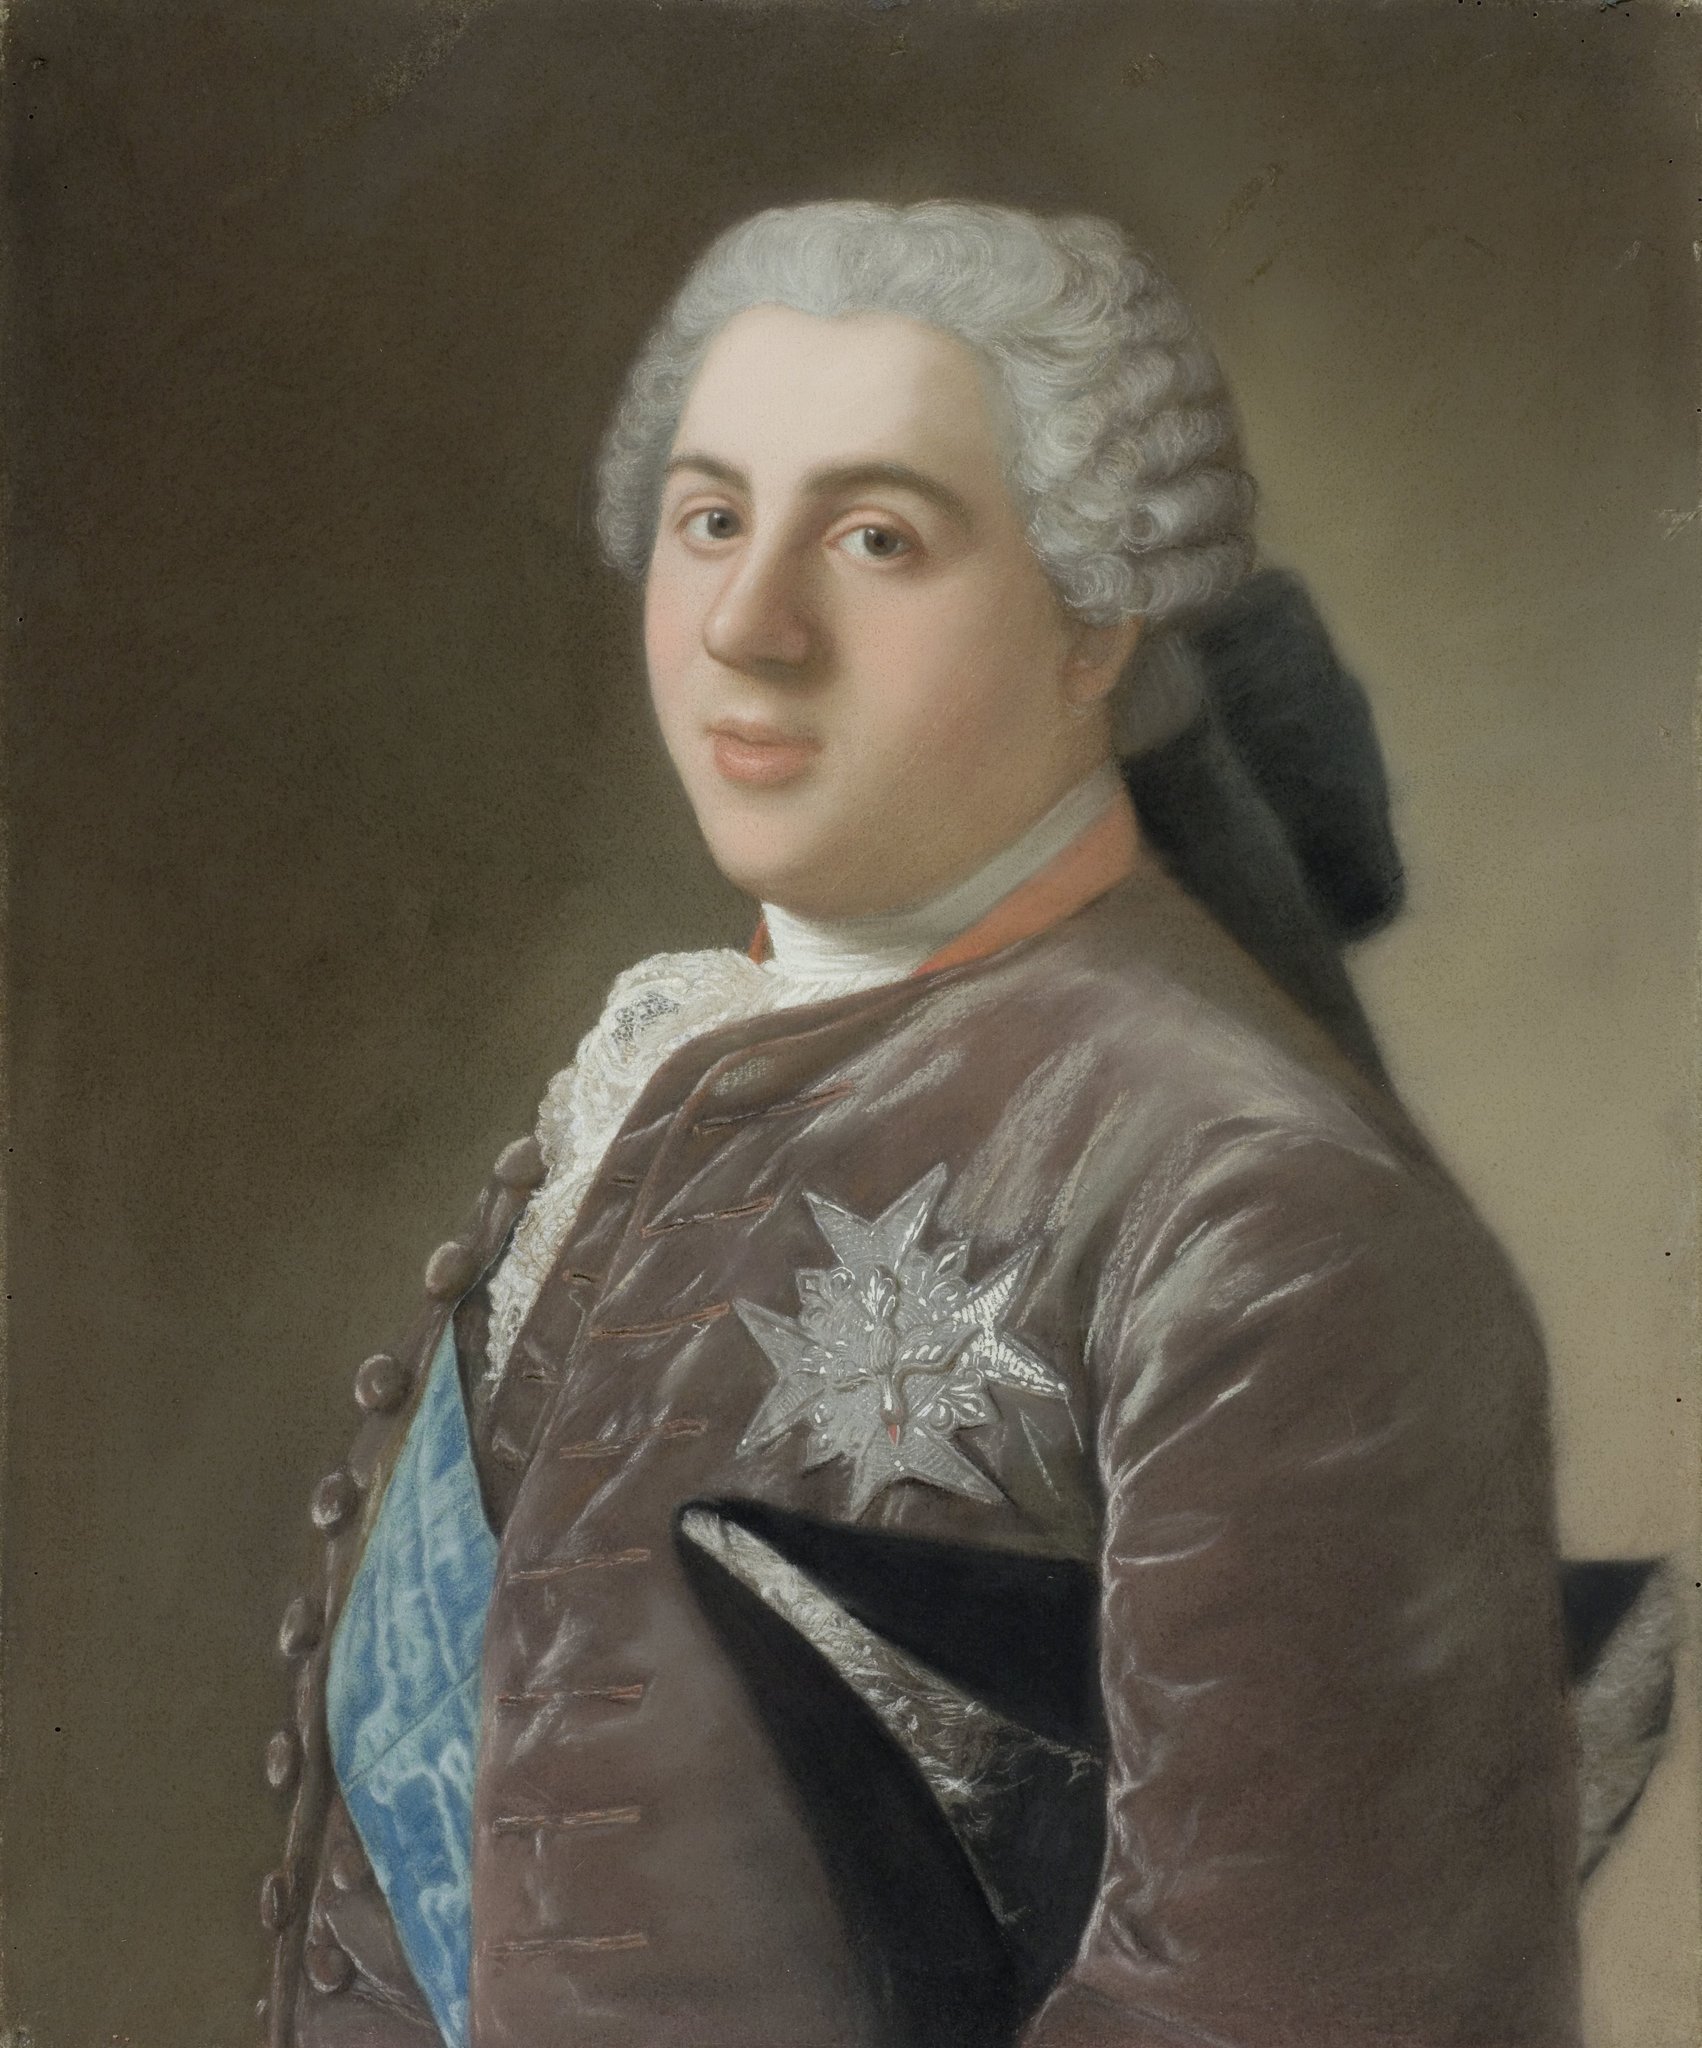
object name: pastel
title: Louis de Bourbon, Dauphin of France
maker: jean-etienne liotard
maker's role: painter, print maker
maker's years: 1702-1789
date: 1749-1750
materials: paper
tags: lodewijk van frankrijk (dauphin van frankrijk), historical persons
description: Almost certainly made during Liotard’s successful campaign of portraiture at Versailles, this pastel is one of the many replicas of commissioned portraits of distinguished persons he kept for himself. Despite the insignia of the Order of the Saint-Esprit, it is an unusually informal presentation of the French crown prince, eldest son of Louis XV and father of Louis XVI.